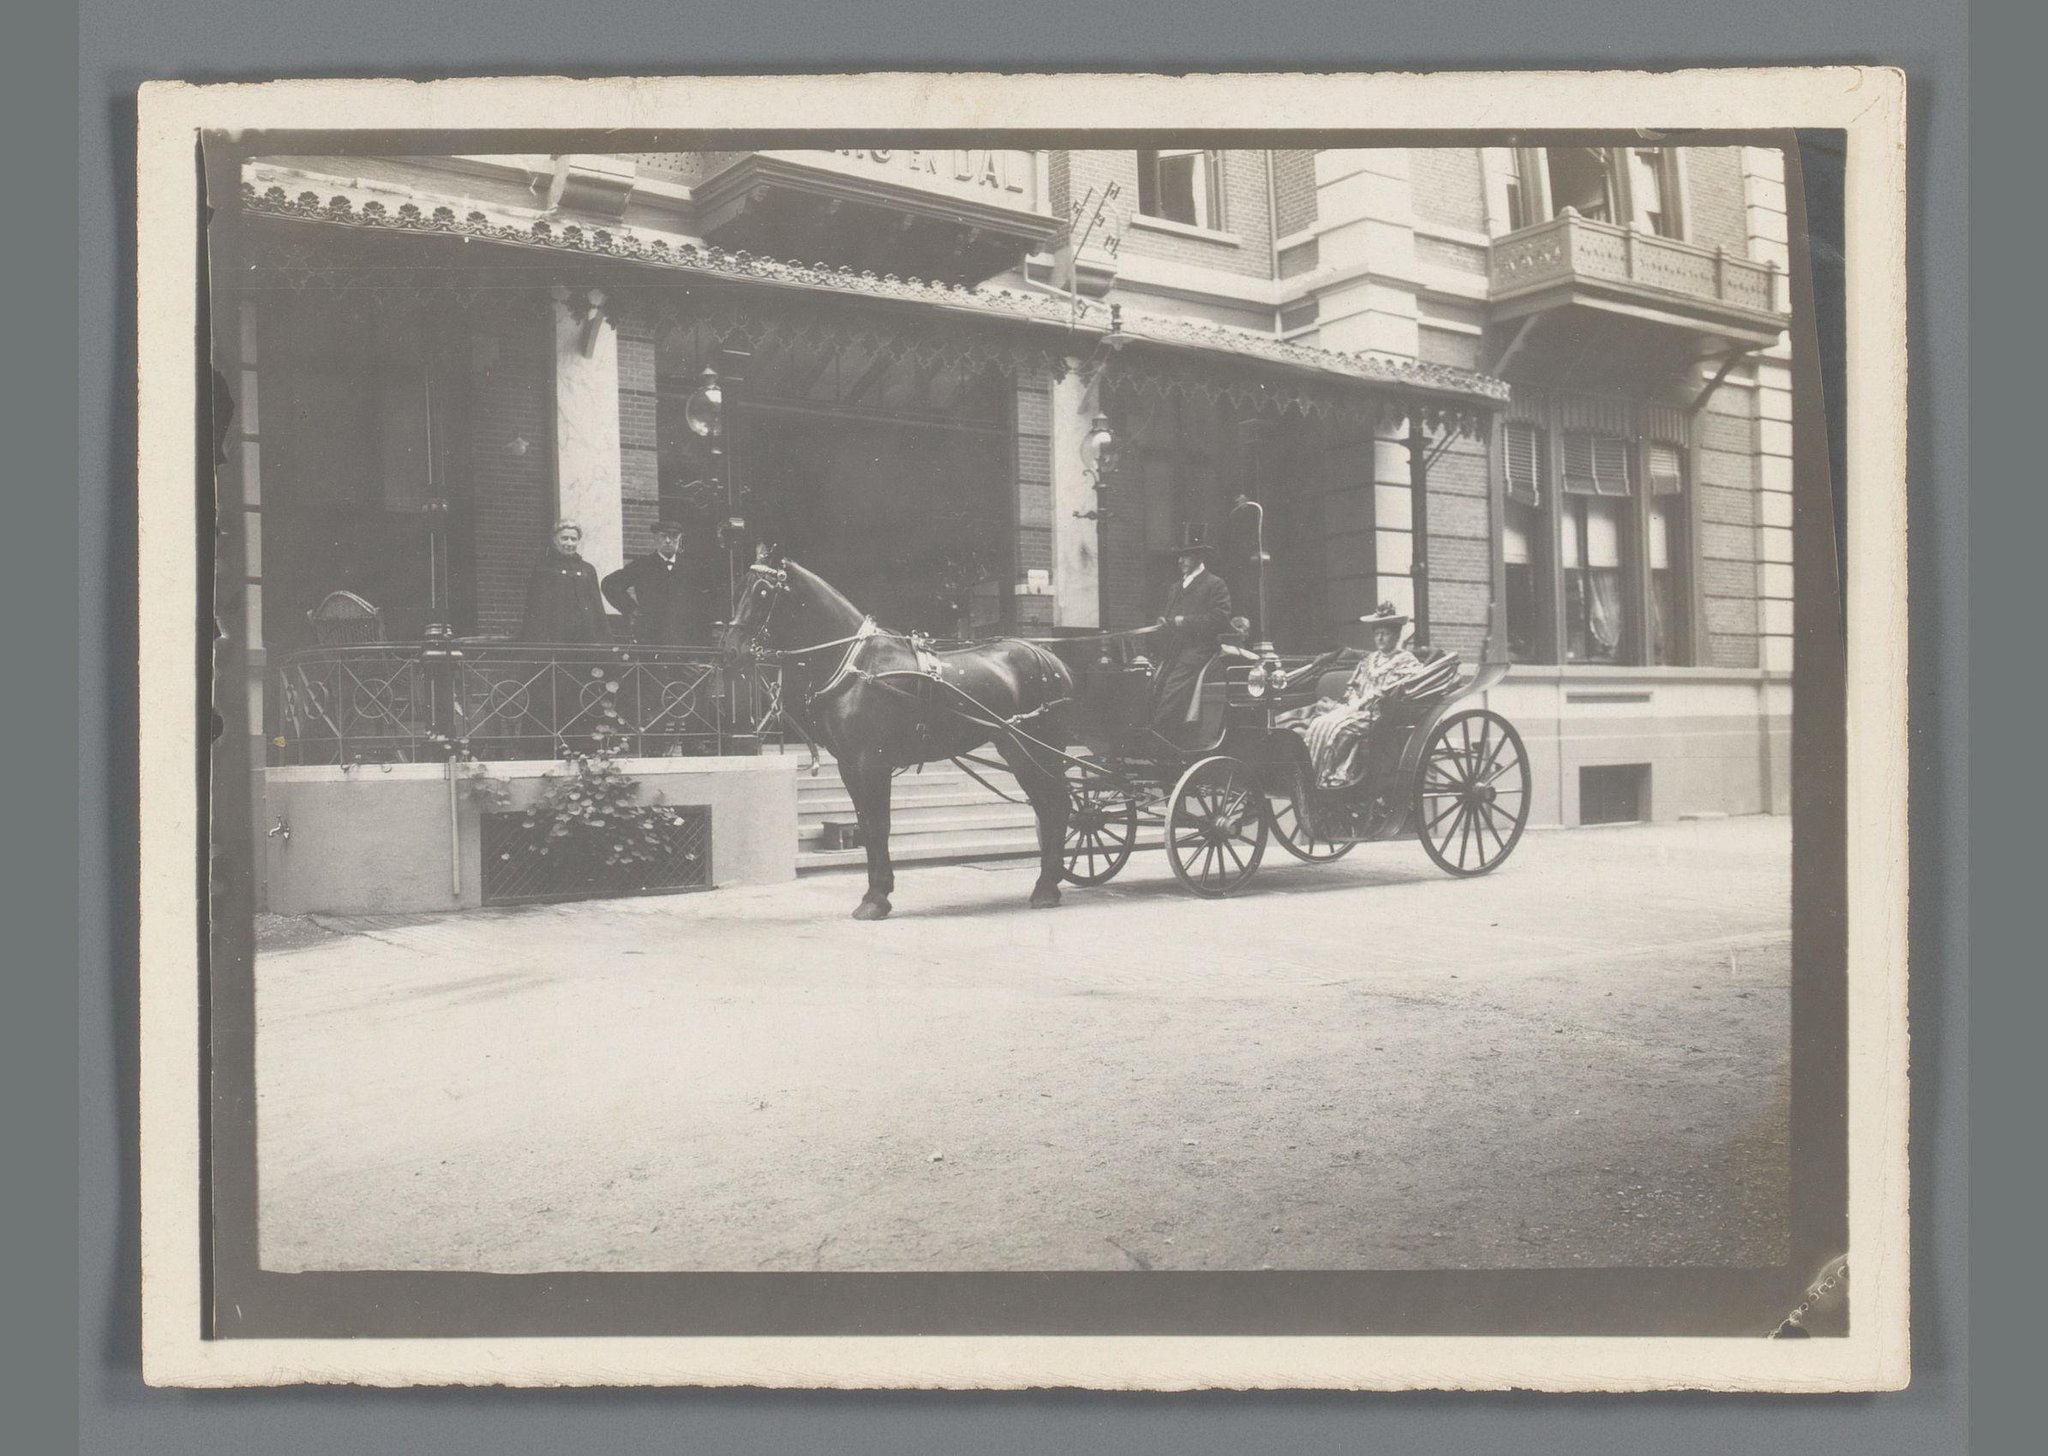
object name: photograph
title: Paardenkoets met bestuurder en zittende vrouw, vermoedelijk de dokterskoets van Piet de Jong, voor Hotel Groot Berg en Dal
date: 1895-1918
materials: paper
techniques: gelatin silver print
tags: four-wheeled vehicle drawn by one animal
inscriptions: inscription: ‘Wrsch dokterskoets v/ P. de Jong’